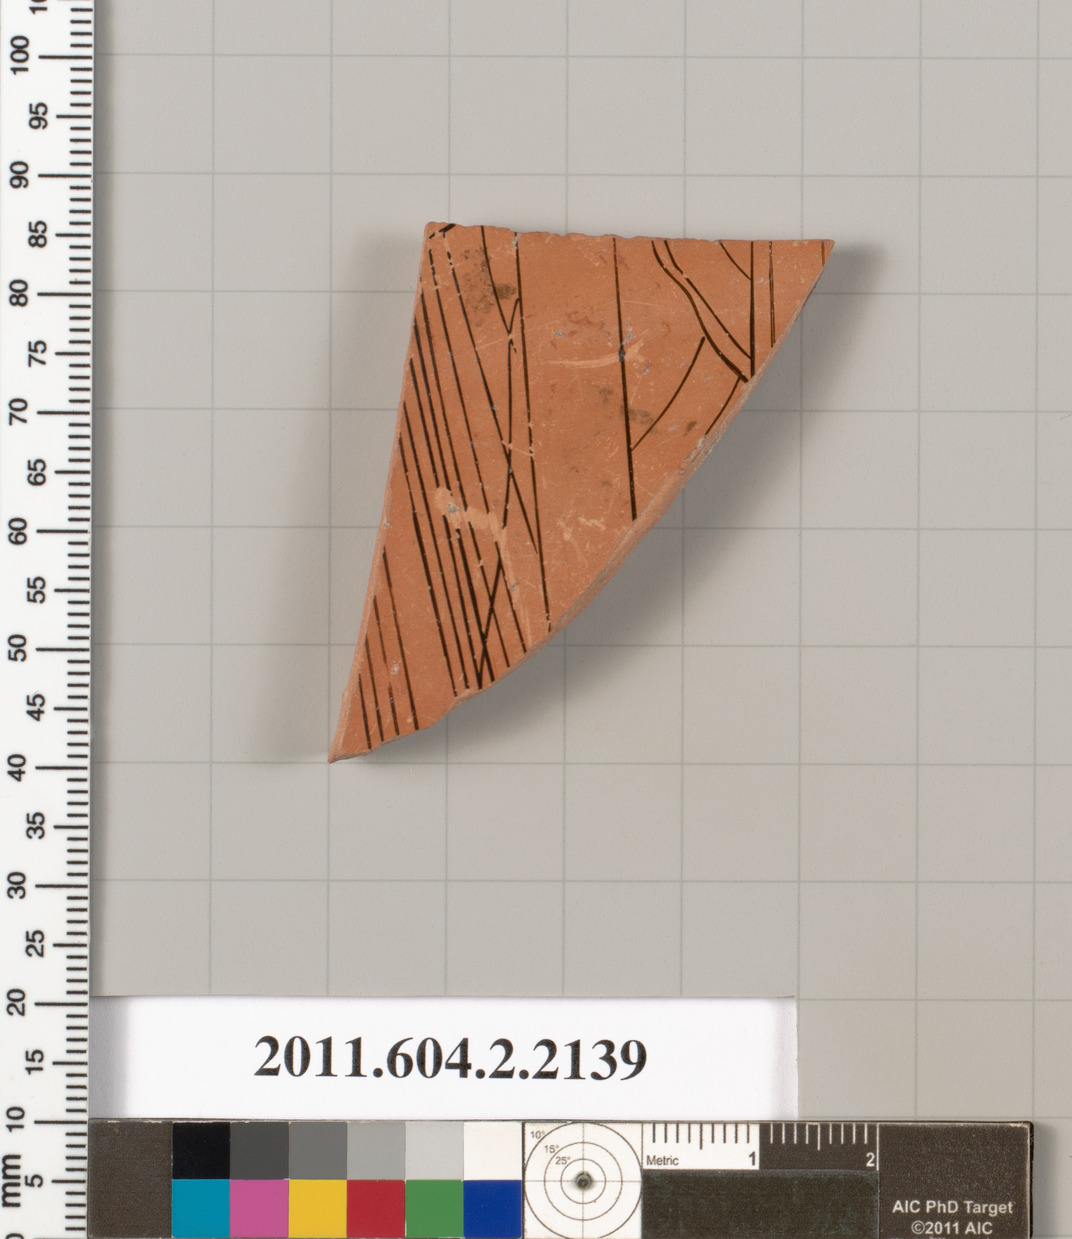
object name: pot fragment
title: Terracotta fragment of a pot; glazed on the inside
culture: greek, attic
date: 480-470 BCE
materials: terracotta